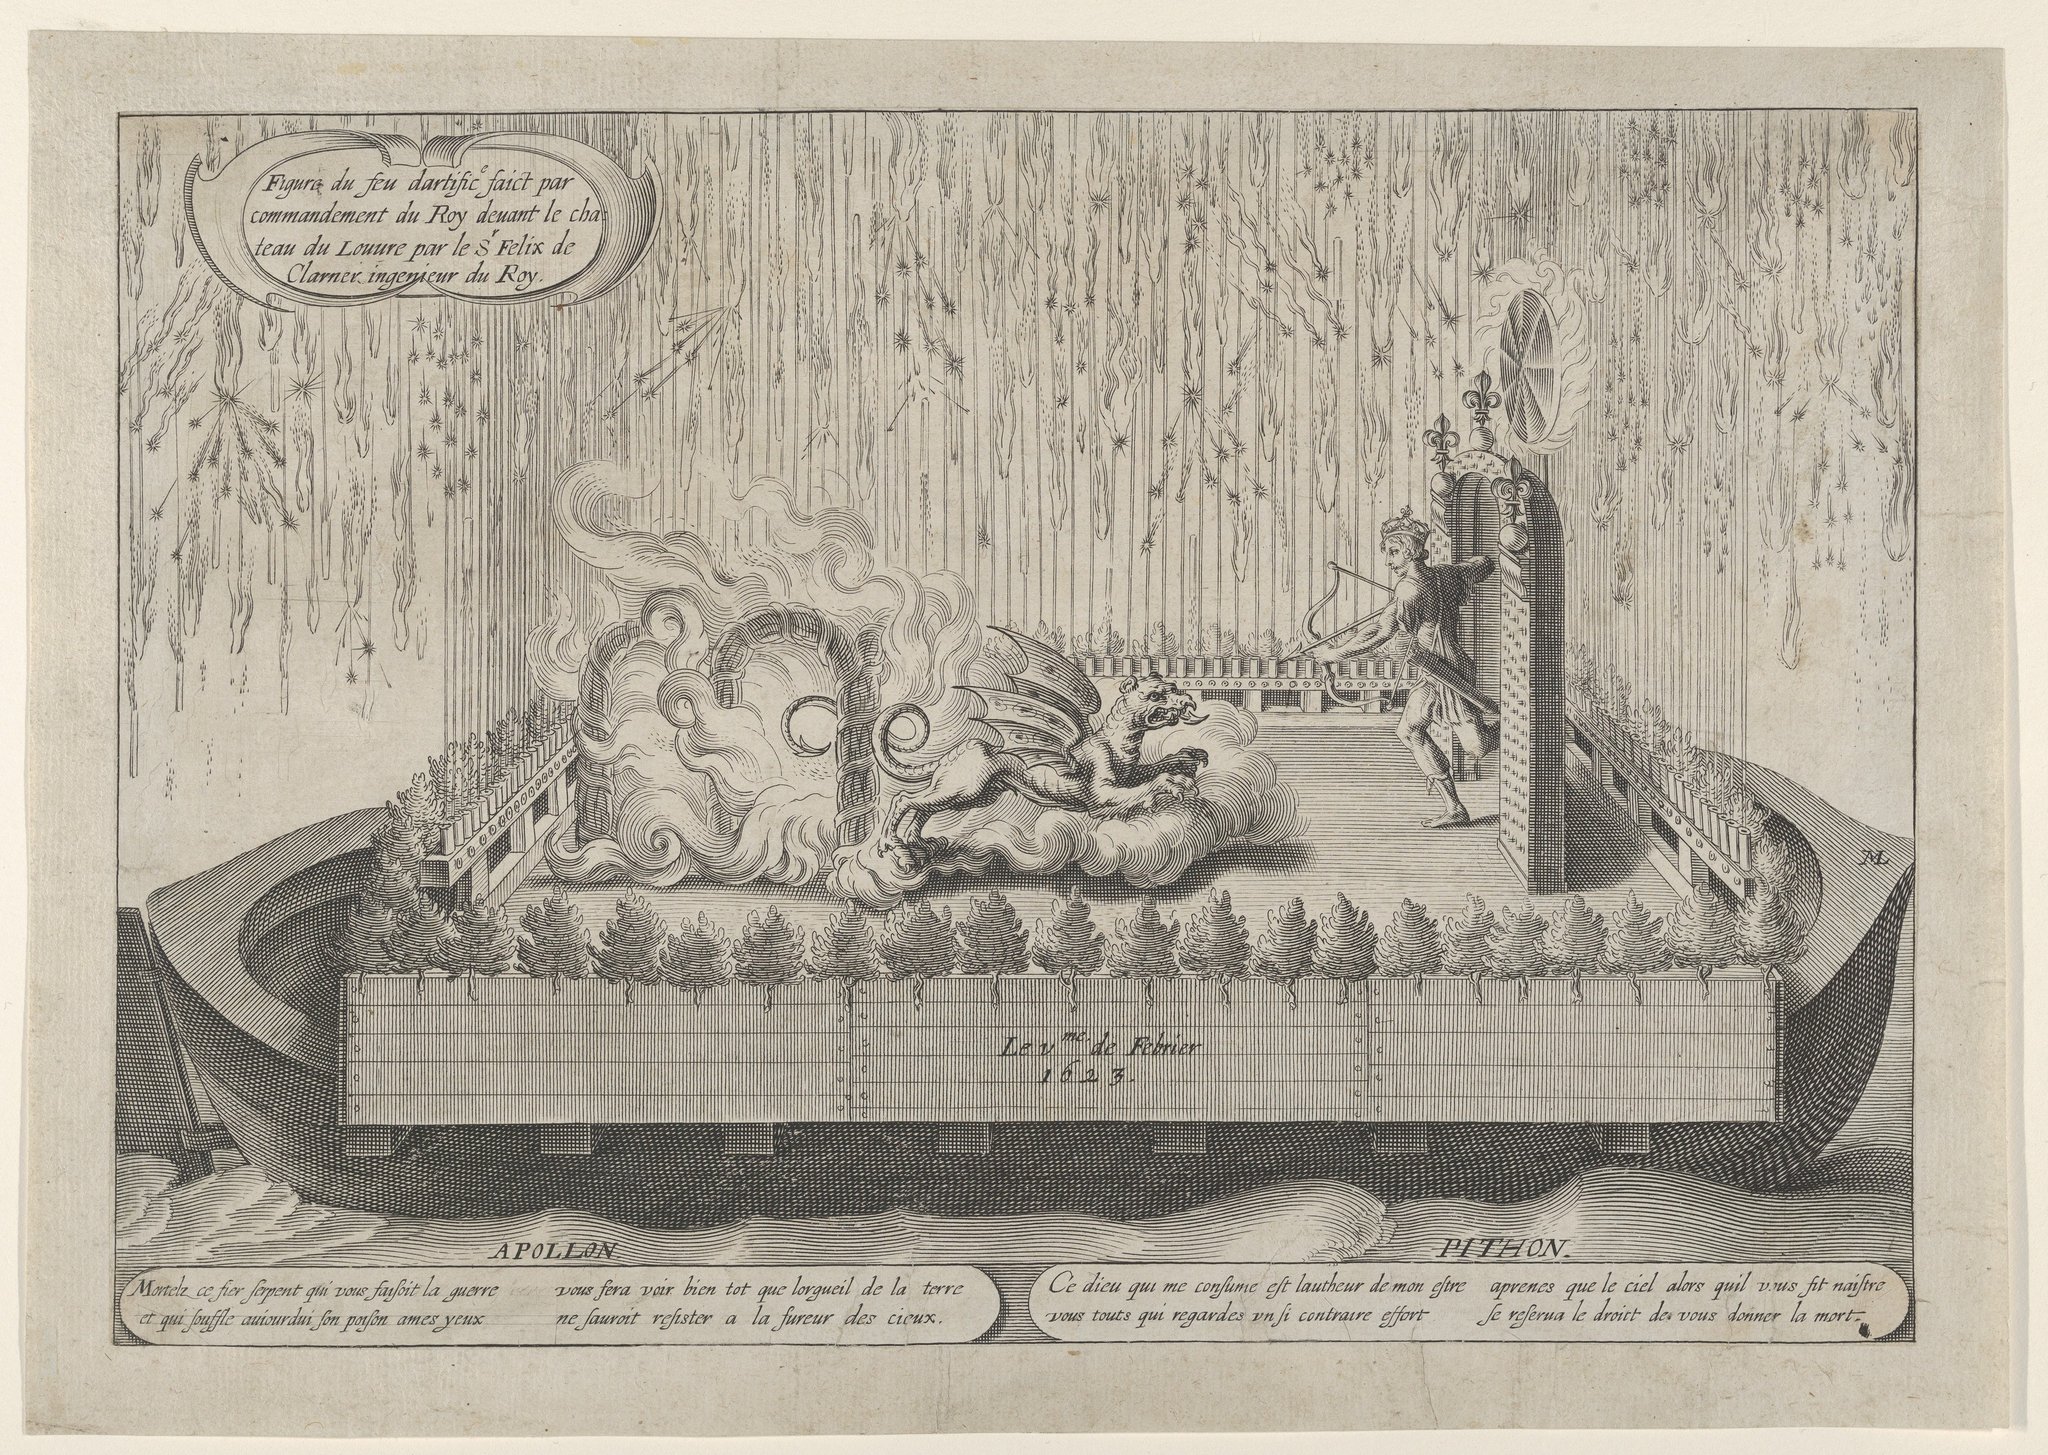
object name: print, fete, ornament architecture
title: Float with Apollo and the Python, from the fireworks display celebrating Louis XIII's return from a military campaign, Paris, February 1623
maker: michel lasne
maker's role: artist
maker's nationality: french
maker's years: 1590-1667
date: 1623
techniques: etching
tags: bow and arrow,fireworks,hunting,apollo